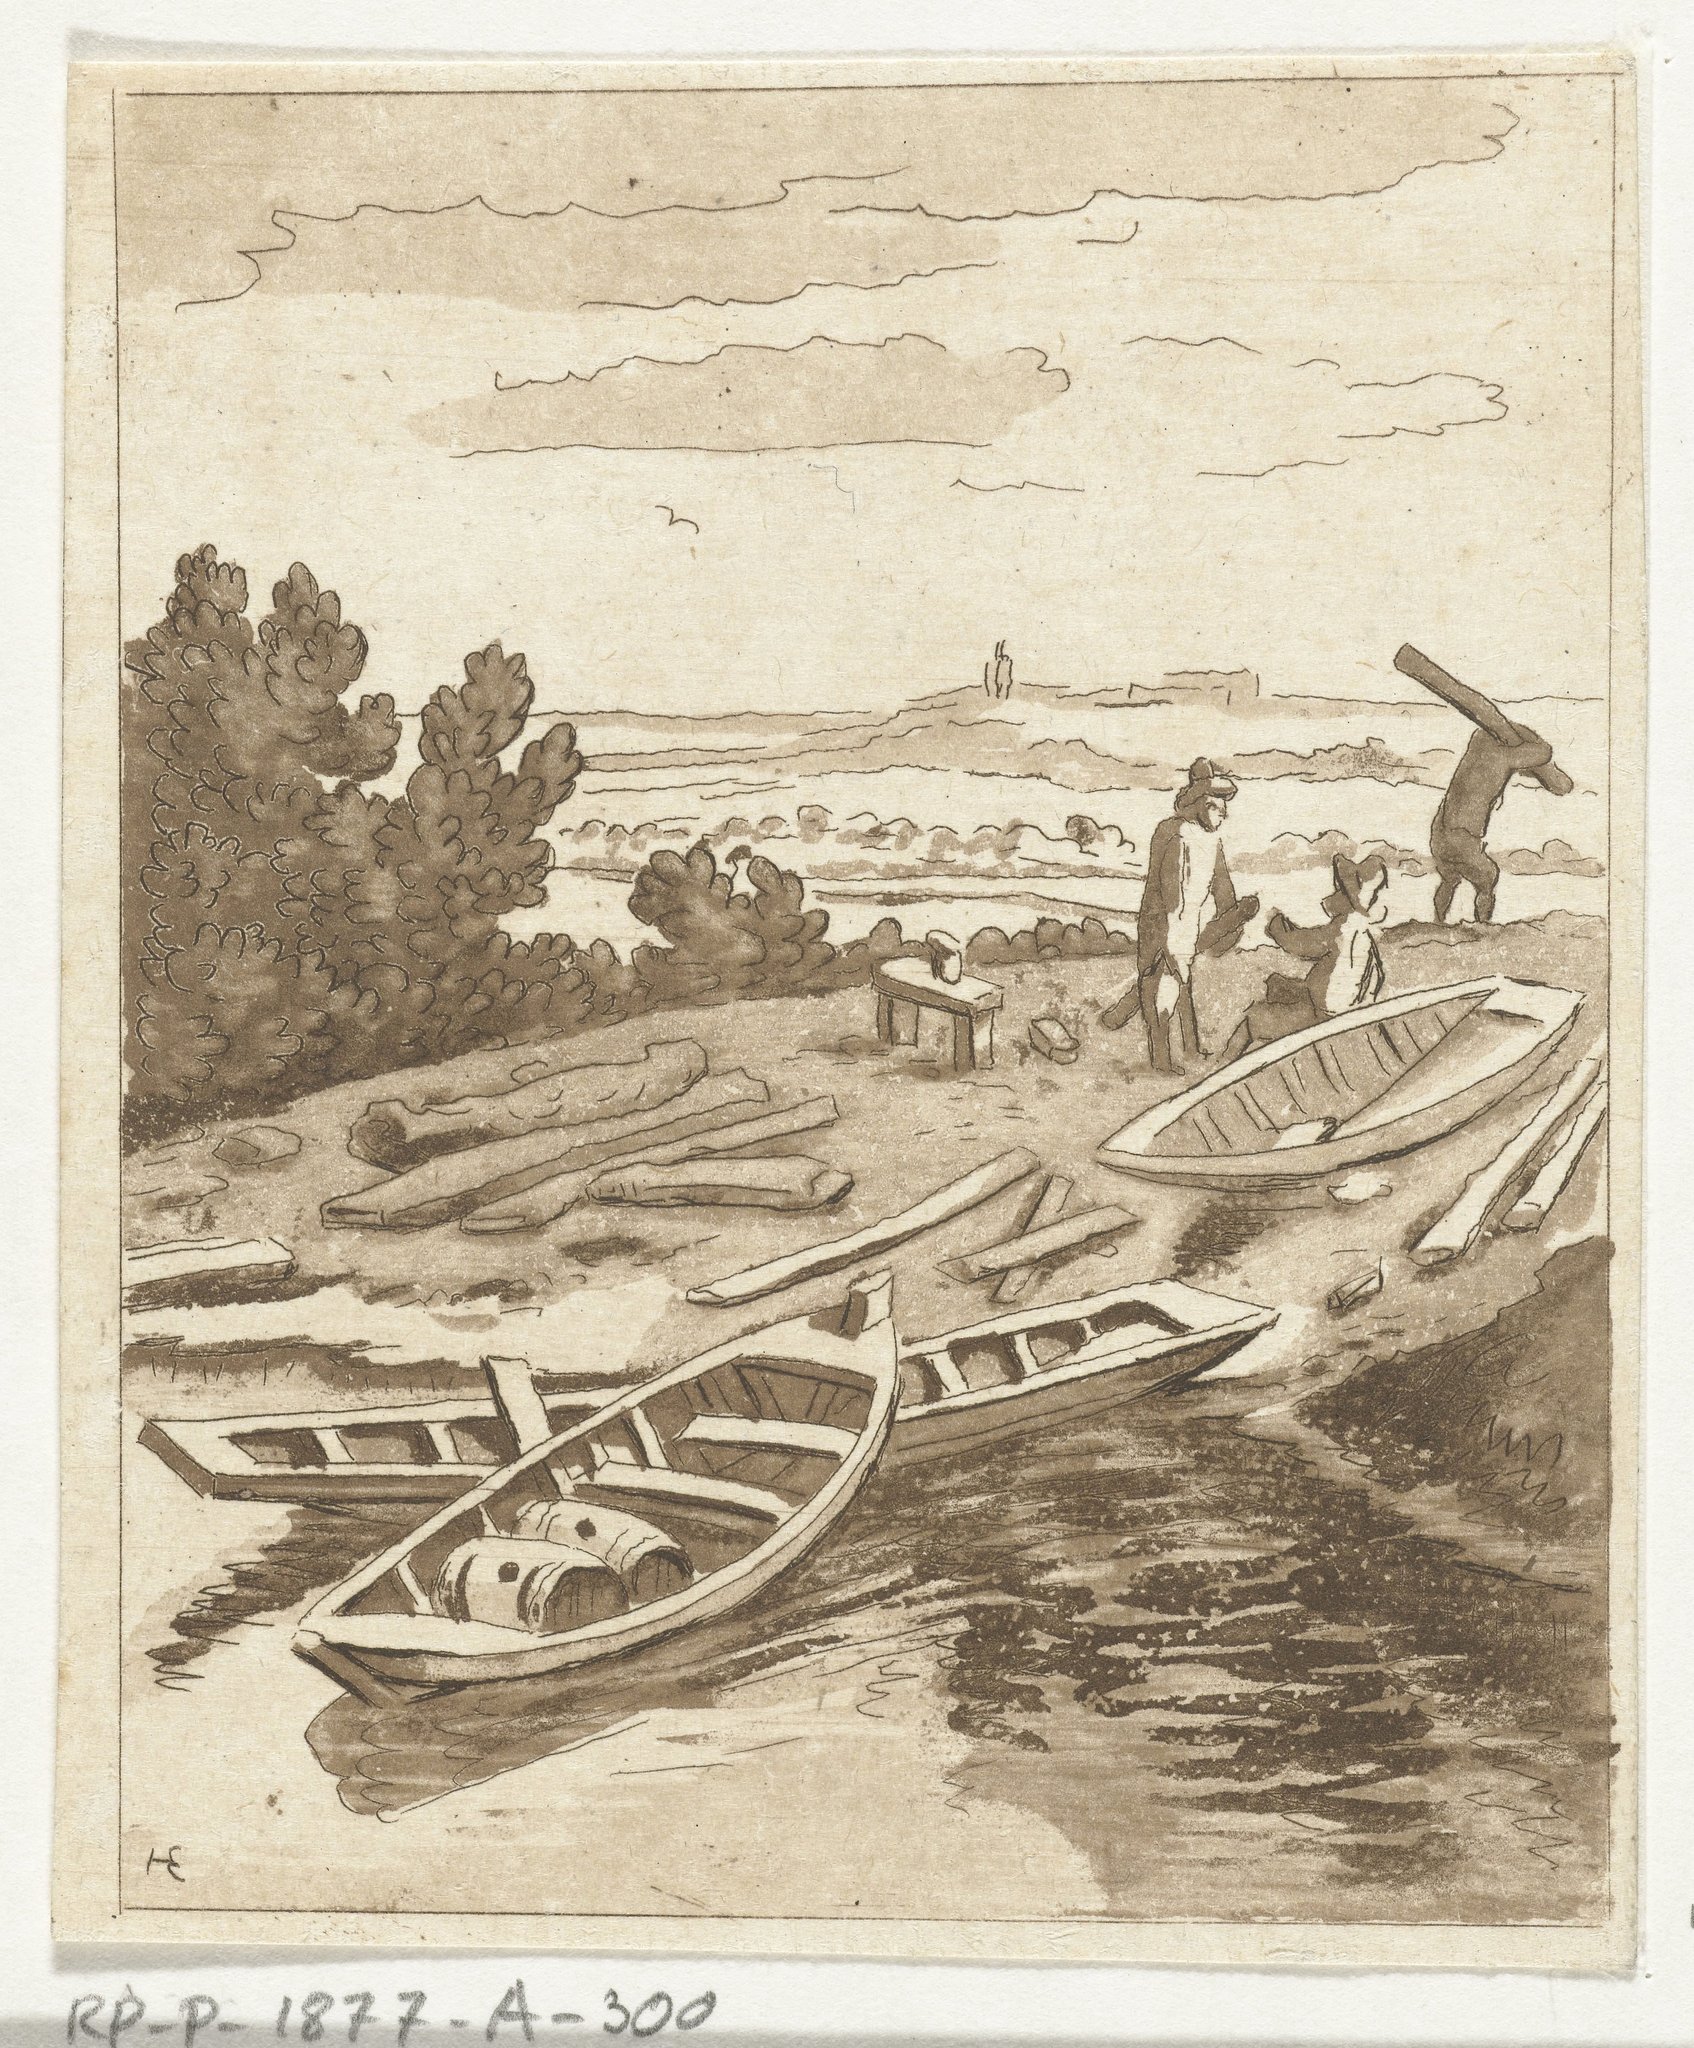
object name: print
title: Roeiboten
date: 1778-1838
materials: paper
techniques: aquatint, etching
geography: netherlands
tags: shipyard, shipdock - cc - more than one ship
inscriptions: collector's mark: Lugt 2228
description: Drie lege boten liggen langs de oever bij een werft. Twee mannen staan bij een van de boten te praten, een derde man draagt een stuk hout op zijn rug en loopt weg. In een van de boten liggen twee houten vaten.